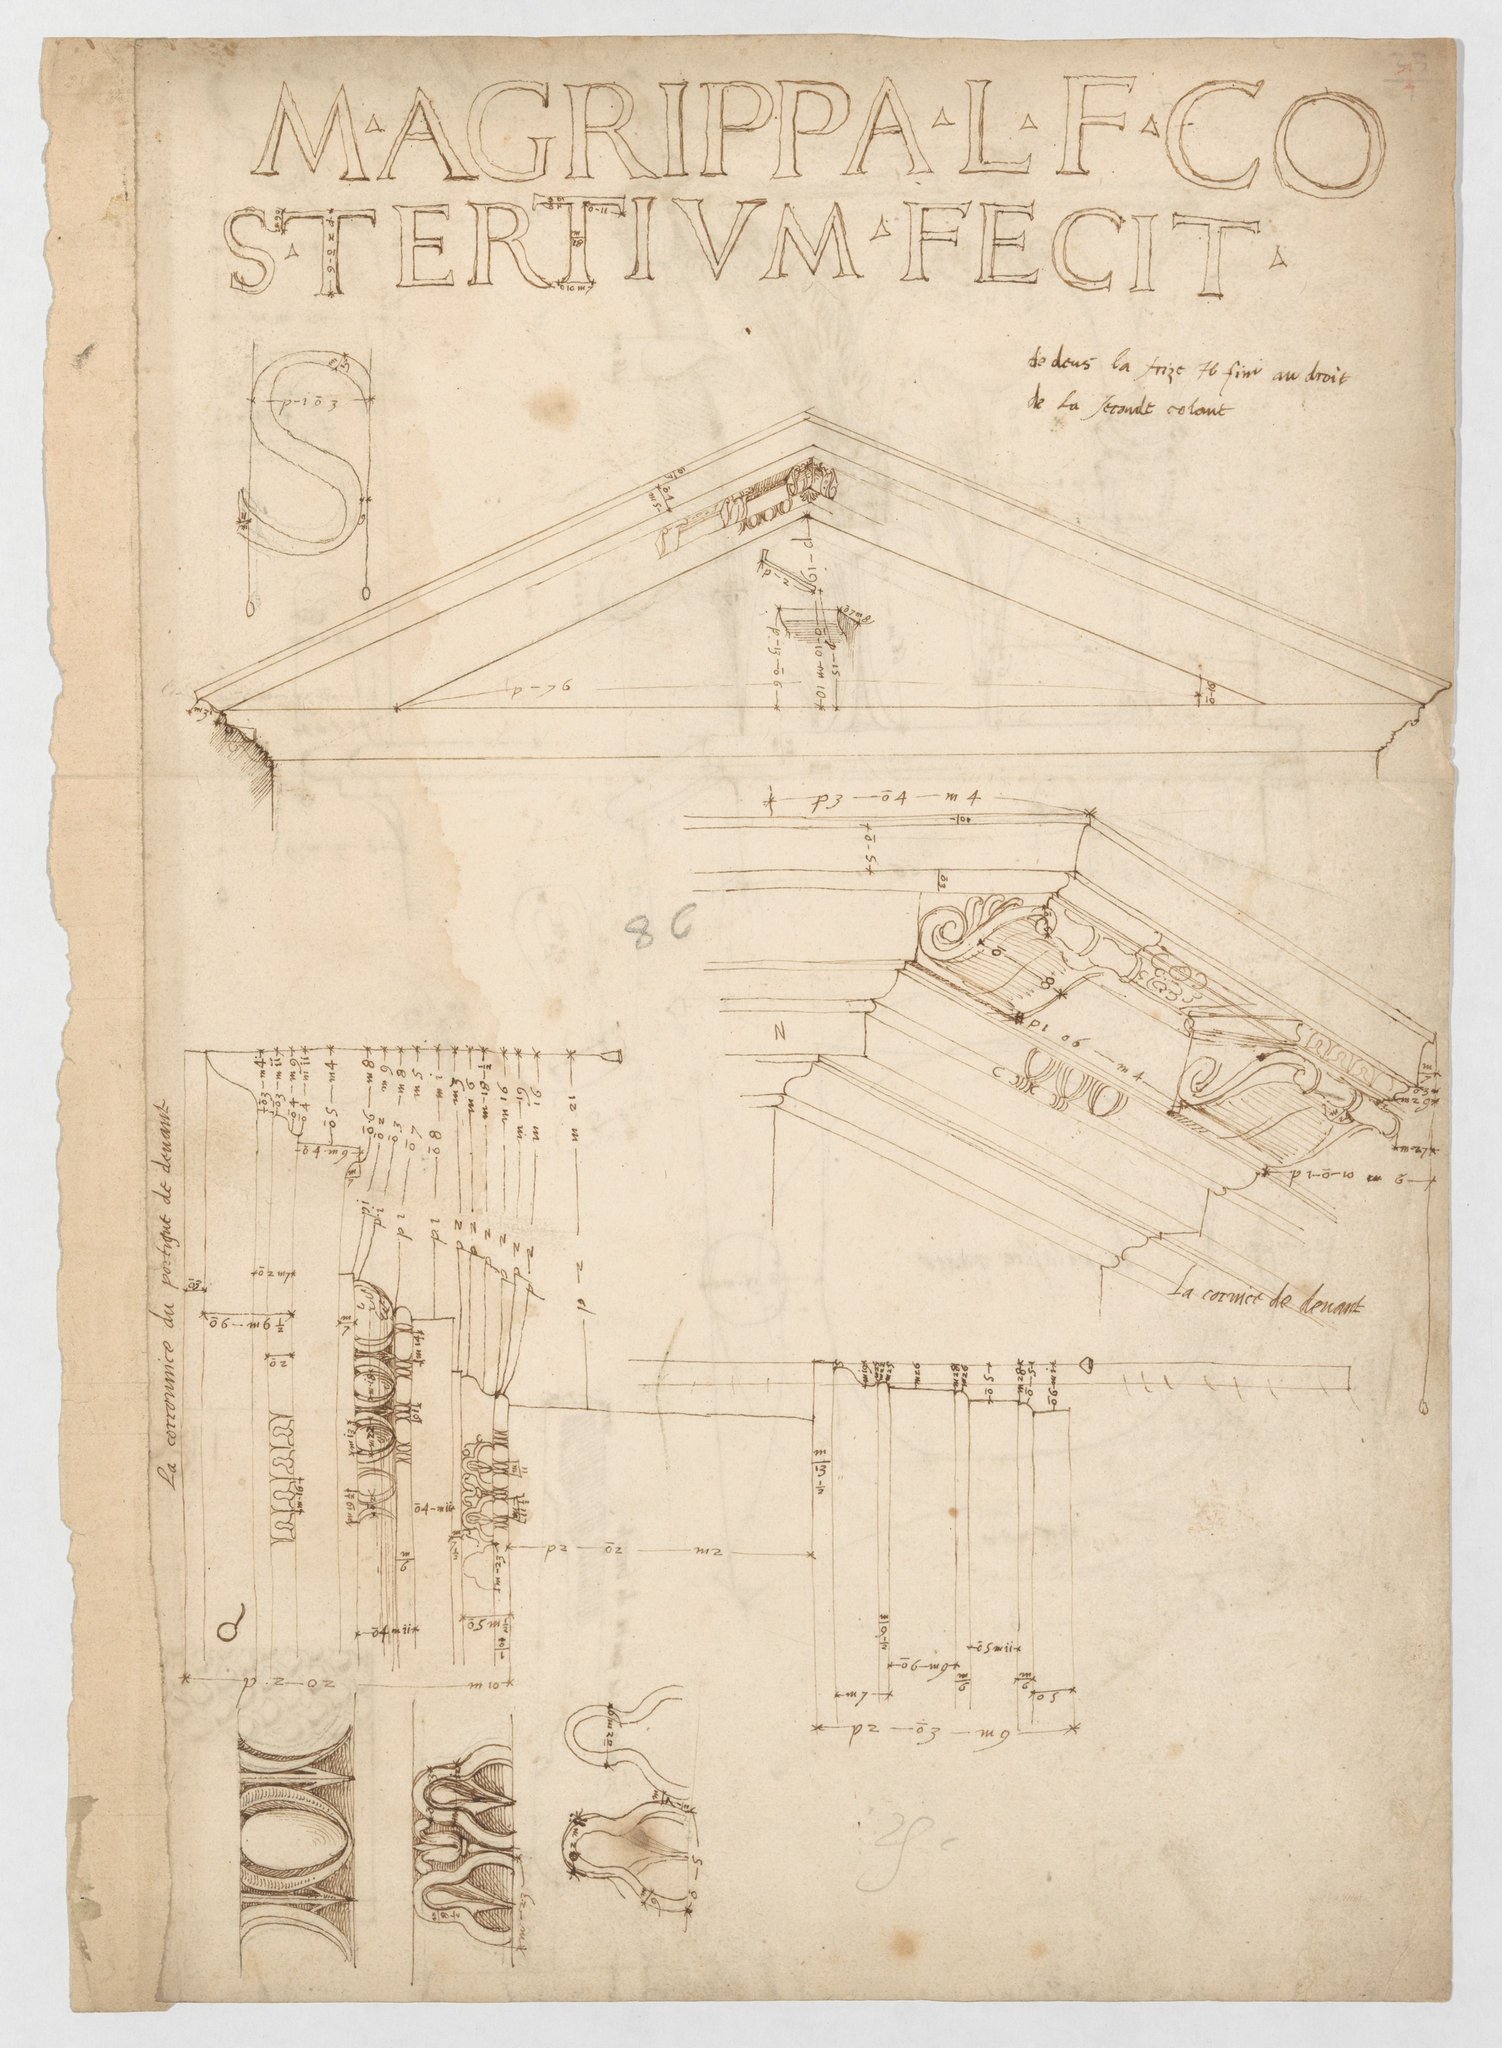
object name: collection ornament architecture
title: Pantheon, pediment details (recto) Pantheon, pilaster capital profile and projected elevation, column diagram, bronze door detail (verso)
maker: anonymous, french, 16th century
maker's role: draftsman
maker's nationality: french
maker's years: 1500-1600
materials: chalk, ink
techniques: incising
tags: architecture